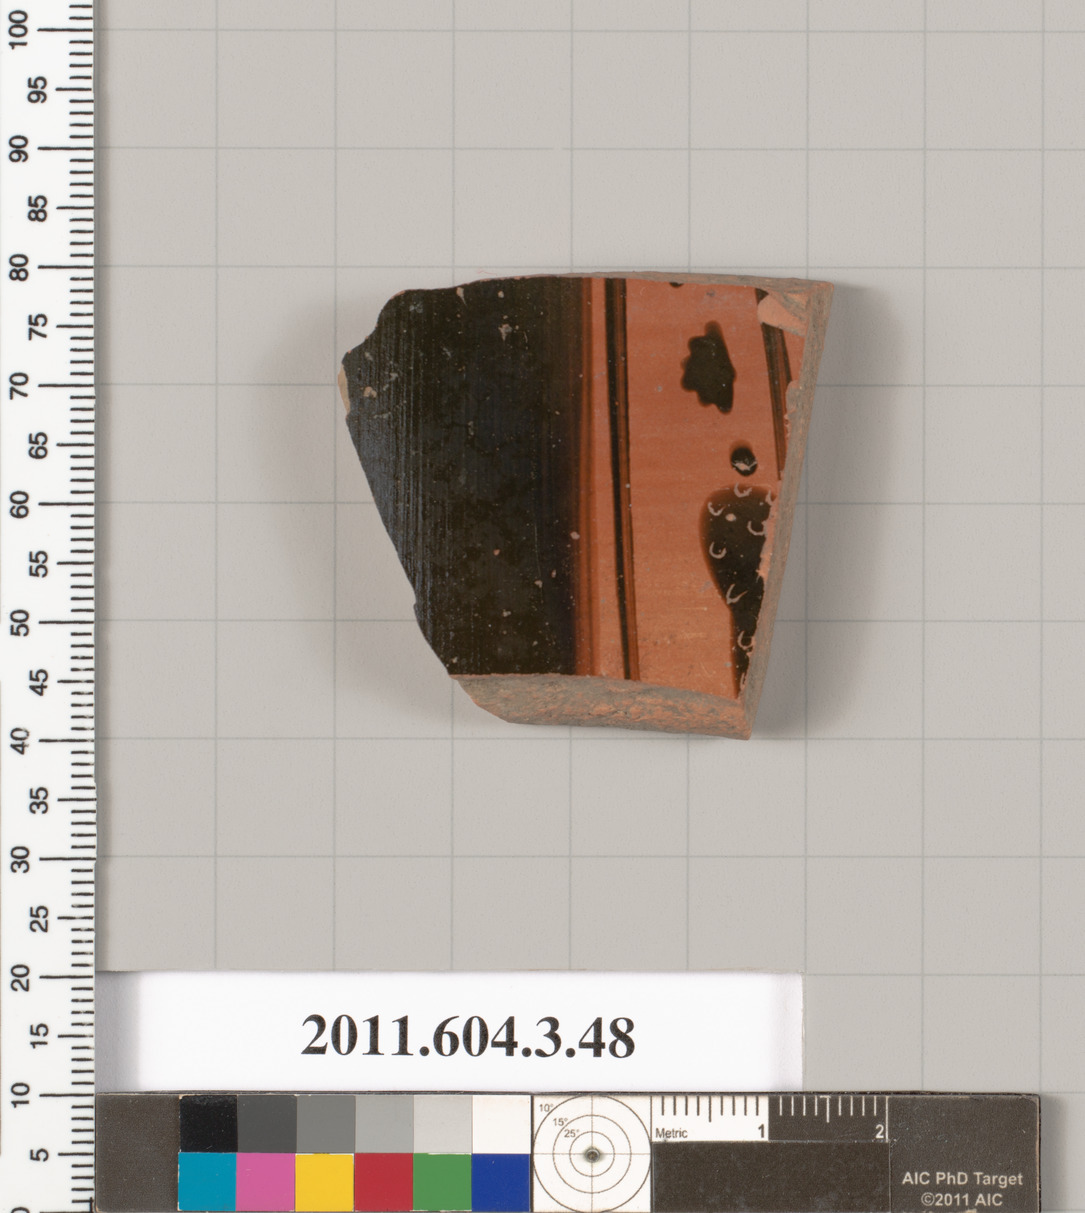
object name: amphora fragment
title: Terracotta fragment of an amphora (jar)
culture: greek, attic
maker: michigan painter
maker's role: artist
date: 525-501 BCE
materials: terracotta